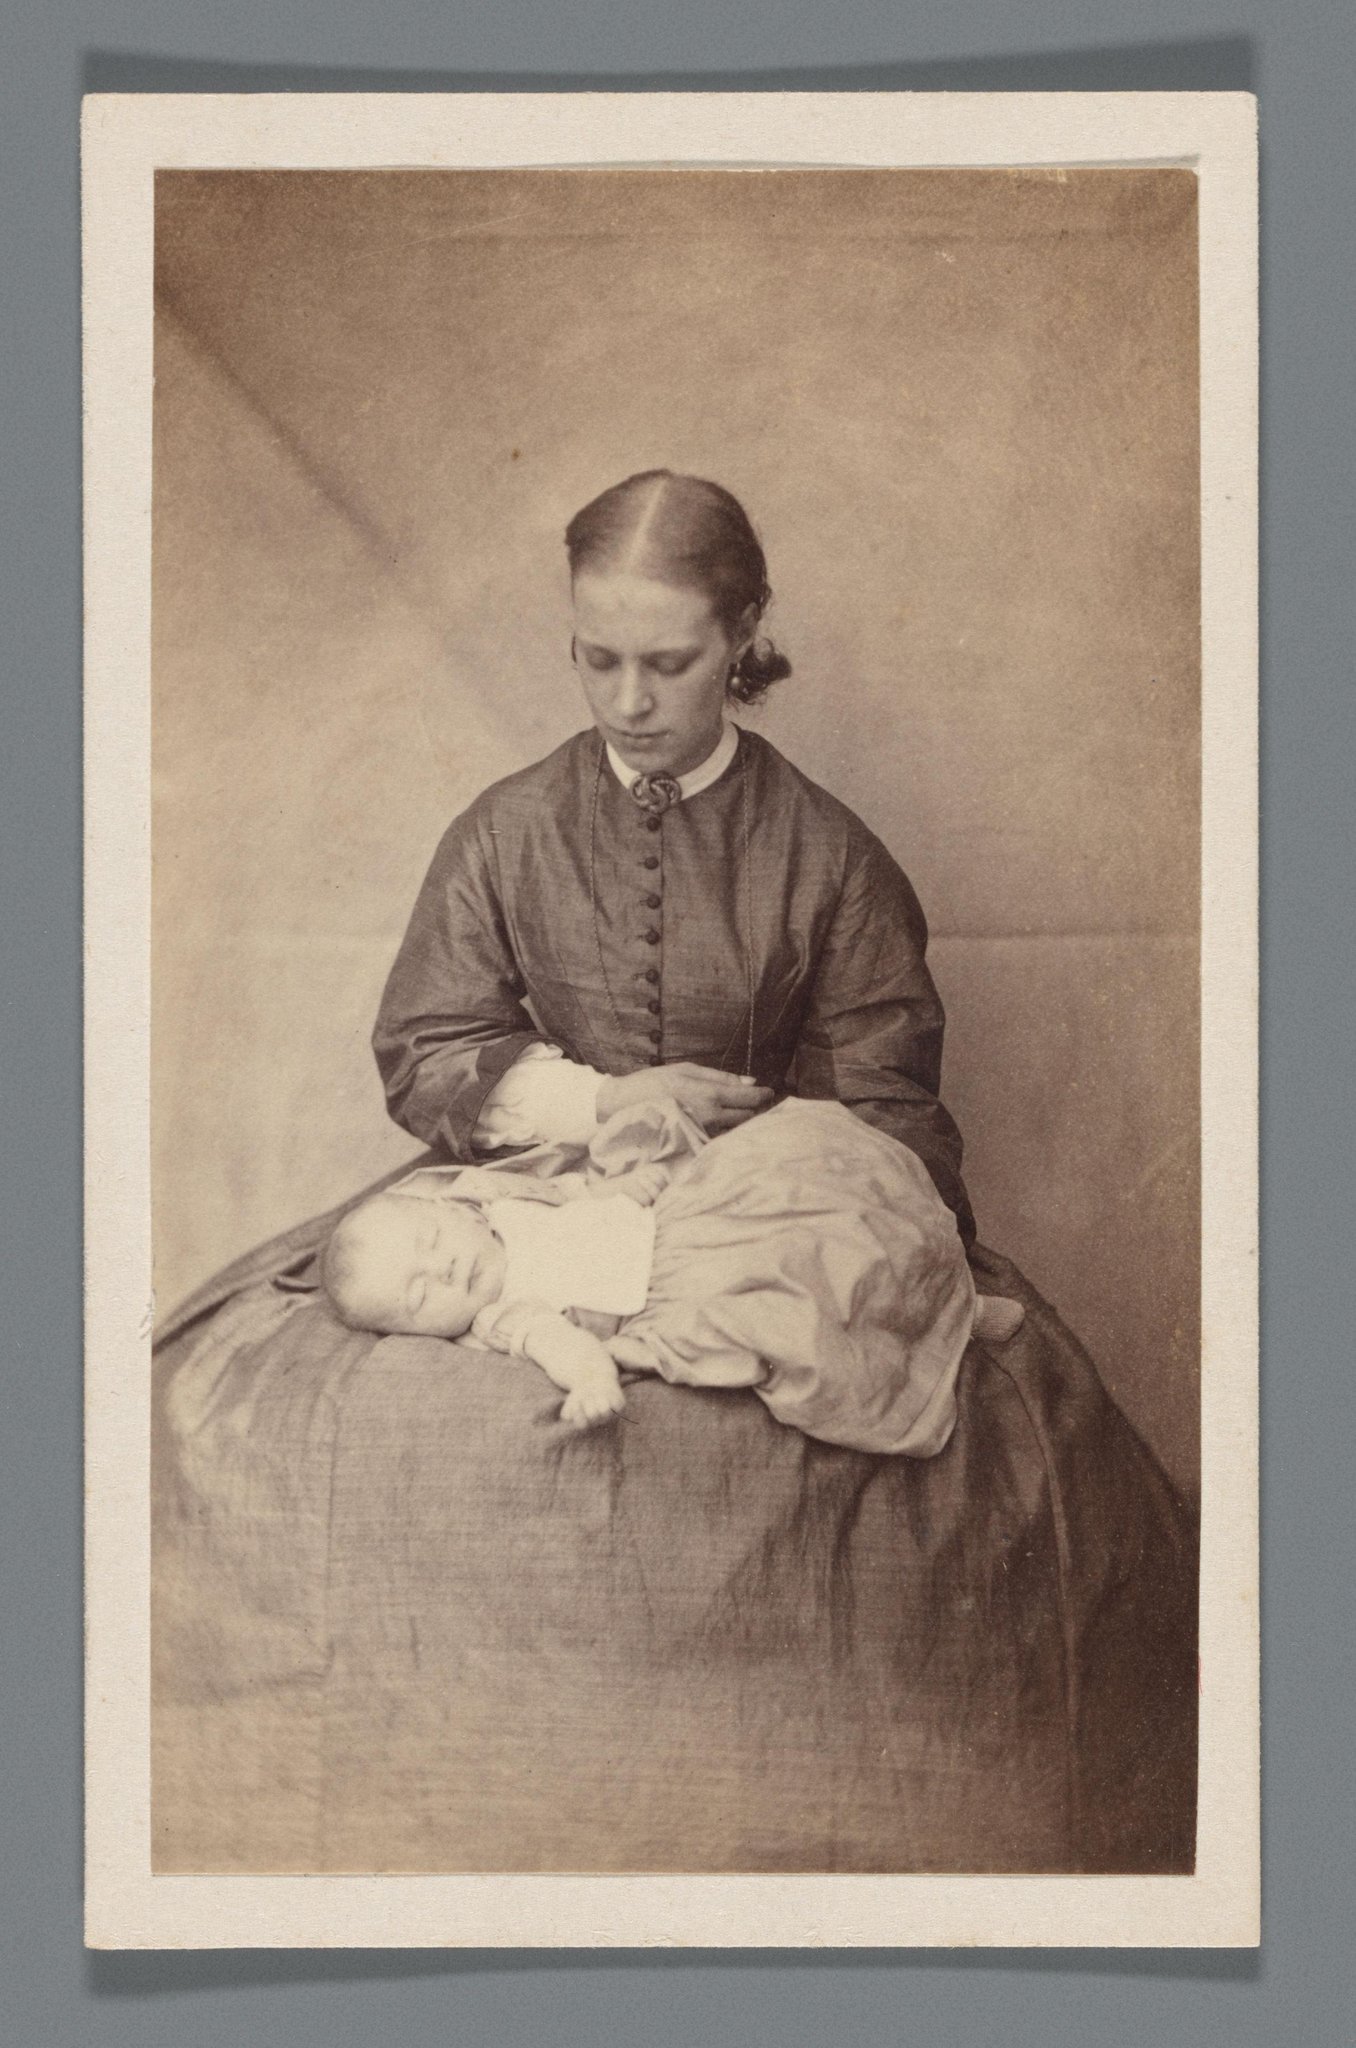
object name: photograph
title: Moeder met overleden kind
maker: Anonymous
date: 1865-1875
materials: cardboard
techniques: albumen print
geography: united states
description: Carte-de-Visite met portret van moeder met op haar schoot een overleden kind.